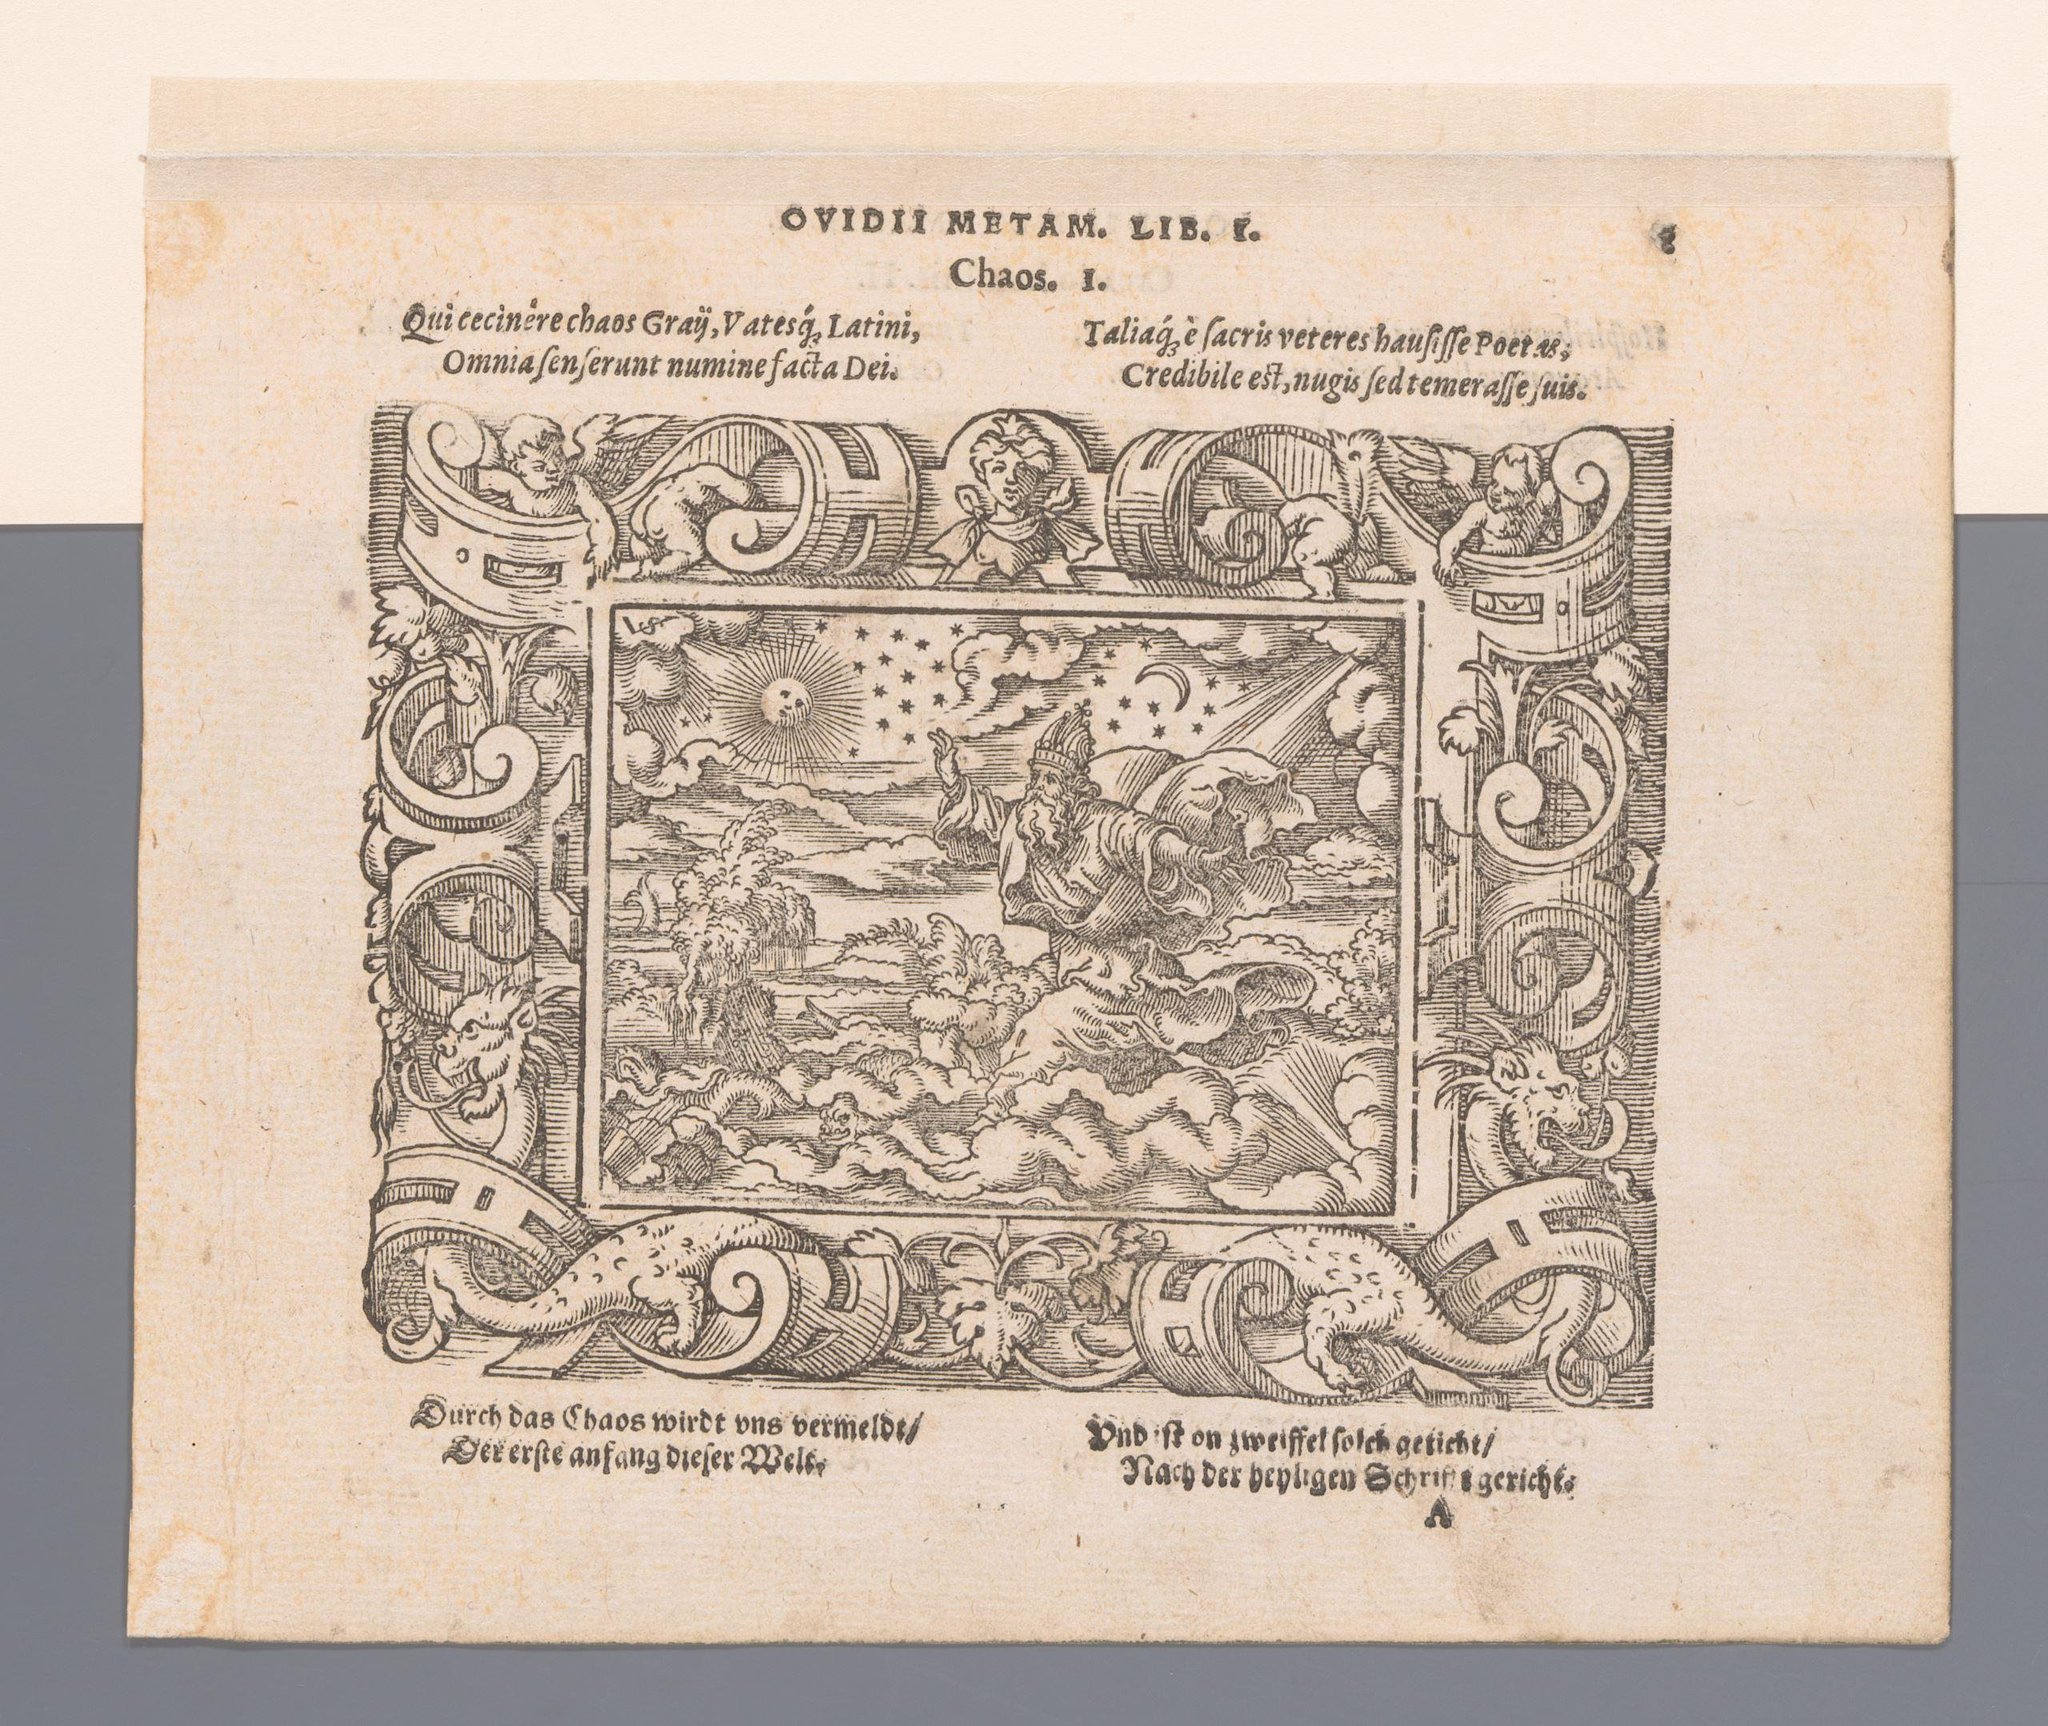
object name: print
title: Chaos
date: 1569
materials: paper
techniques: letterpress printing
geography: nuremberg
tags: 'in the beginning ...' the ordering of chaos (genesis 1:1-2), scrollwork, strapwork ~ ornament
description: Illustratie bij de Metamorfosen van Ovidius, afkomstig uit de publicatie: Posthius, Johannes. Tetrasticha in Ovidii metam. Frankfurt am Main: Georg Rab en Sigmund Feyerabend en erven Weigand Han, 1569. De voorstellingen en ornamentranden van deze boekillustraties zijn van twee aparte blokken gedrukt. Beide werden afzonderlijk van elkaar ook gebruikt voor andere publicaties, en de ornamentranden werden eveneens binnen deze publicatie meerdere keren gebruikt.